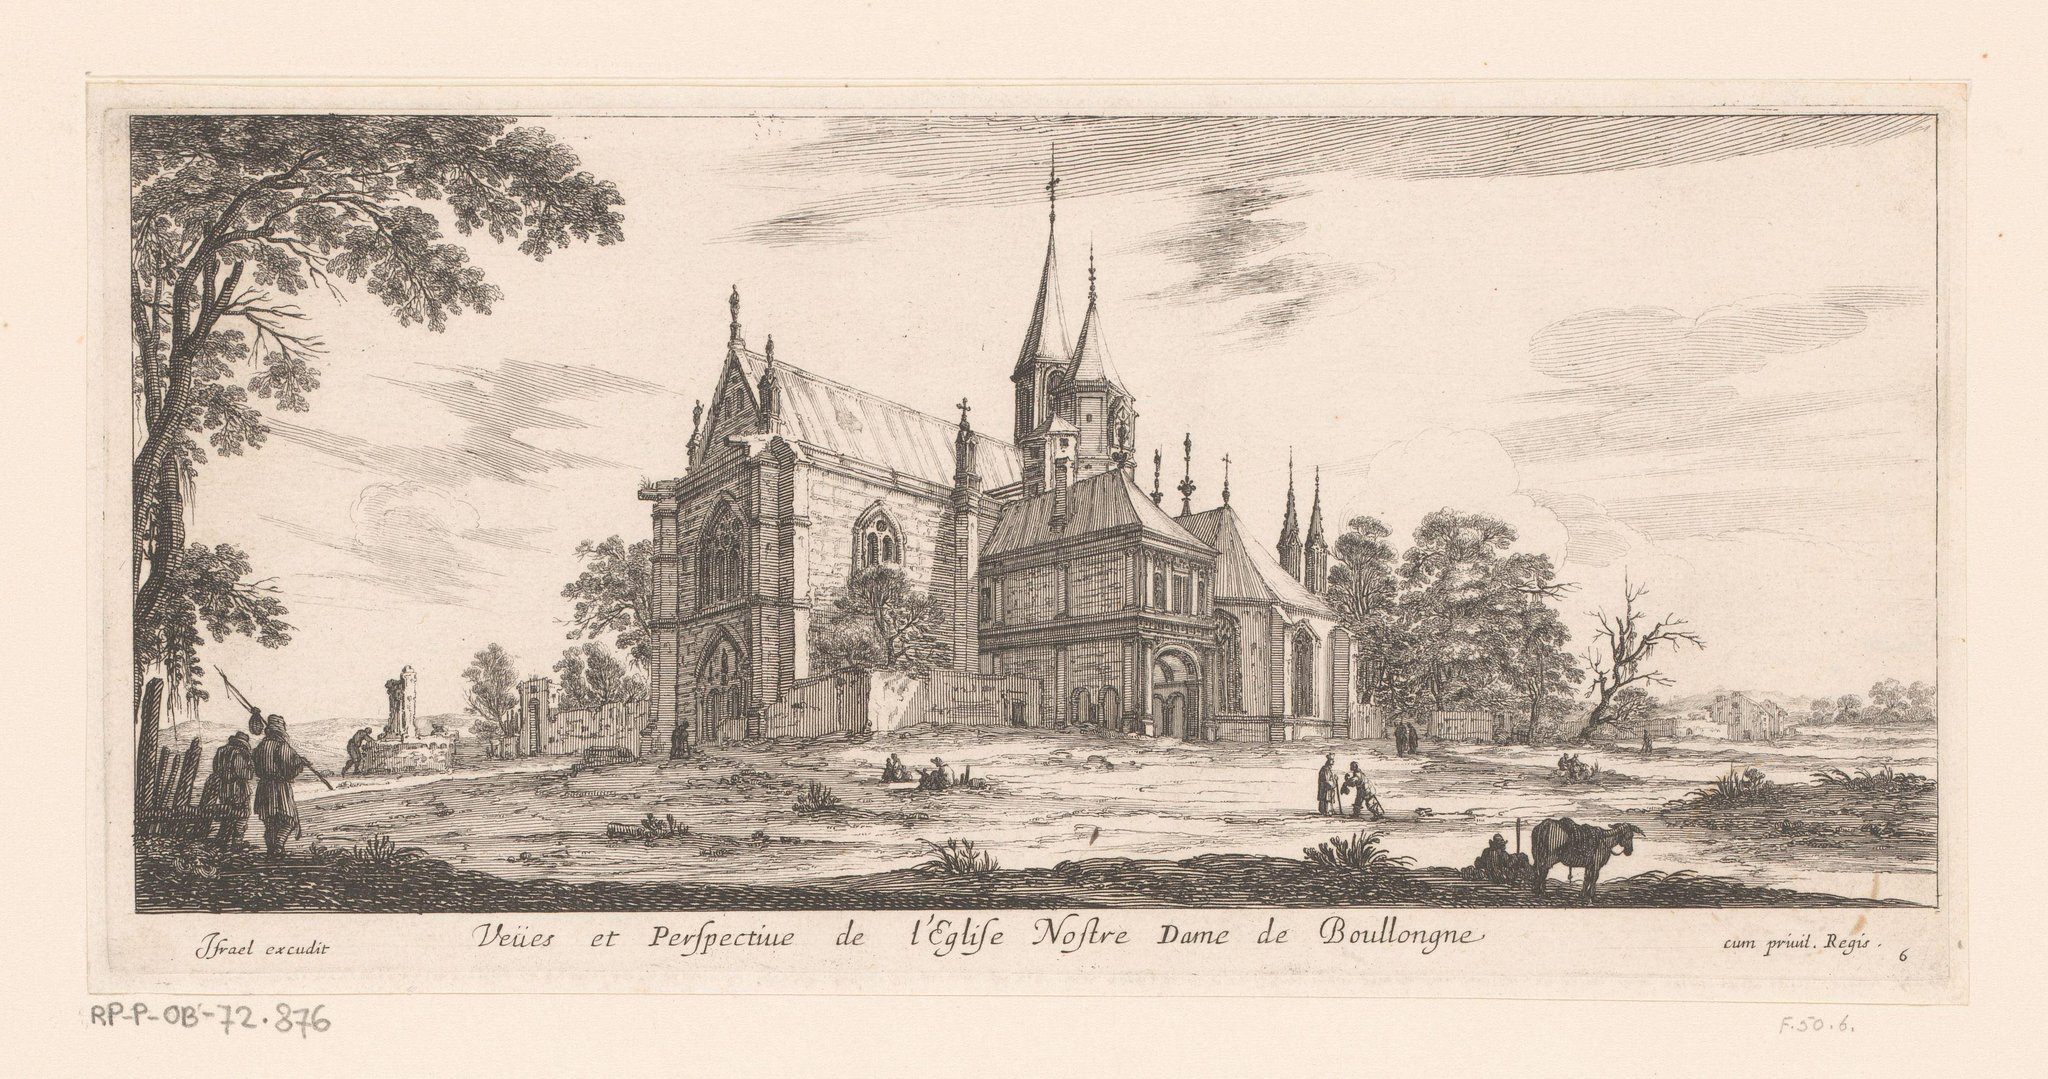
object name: print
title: Vues de Paris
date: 1630-1661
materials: paper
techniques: engraving, etching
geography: france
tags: city-view, and landscape with man-made constructions, church (exterior)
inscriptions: collector's mark: Lugt 240